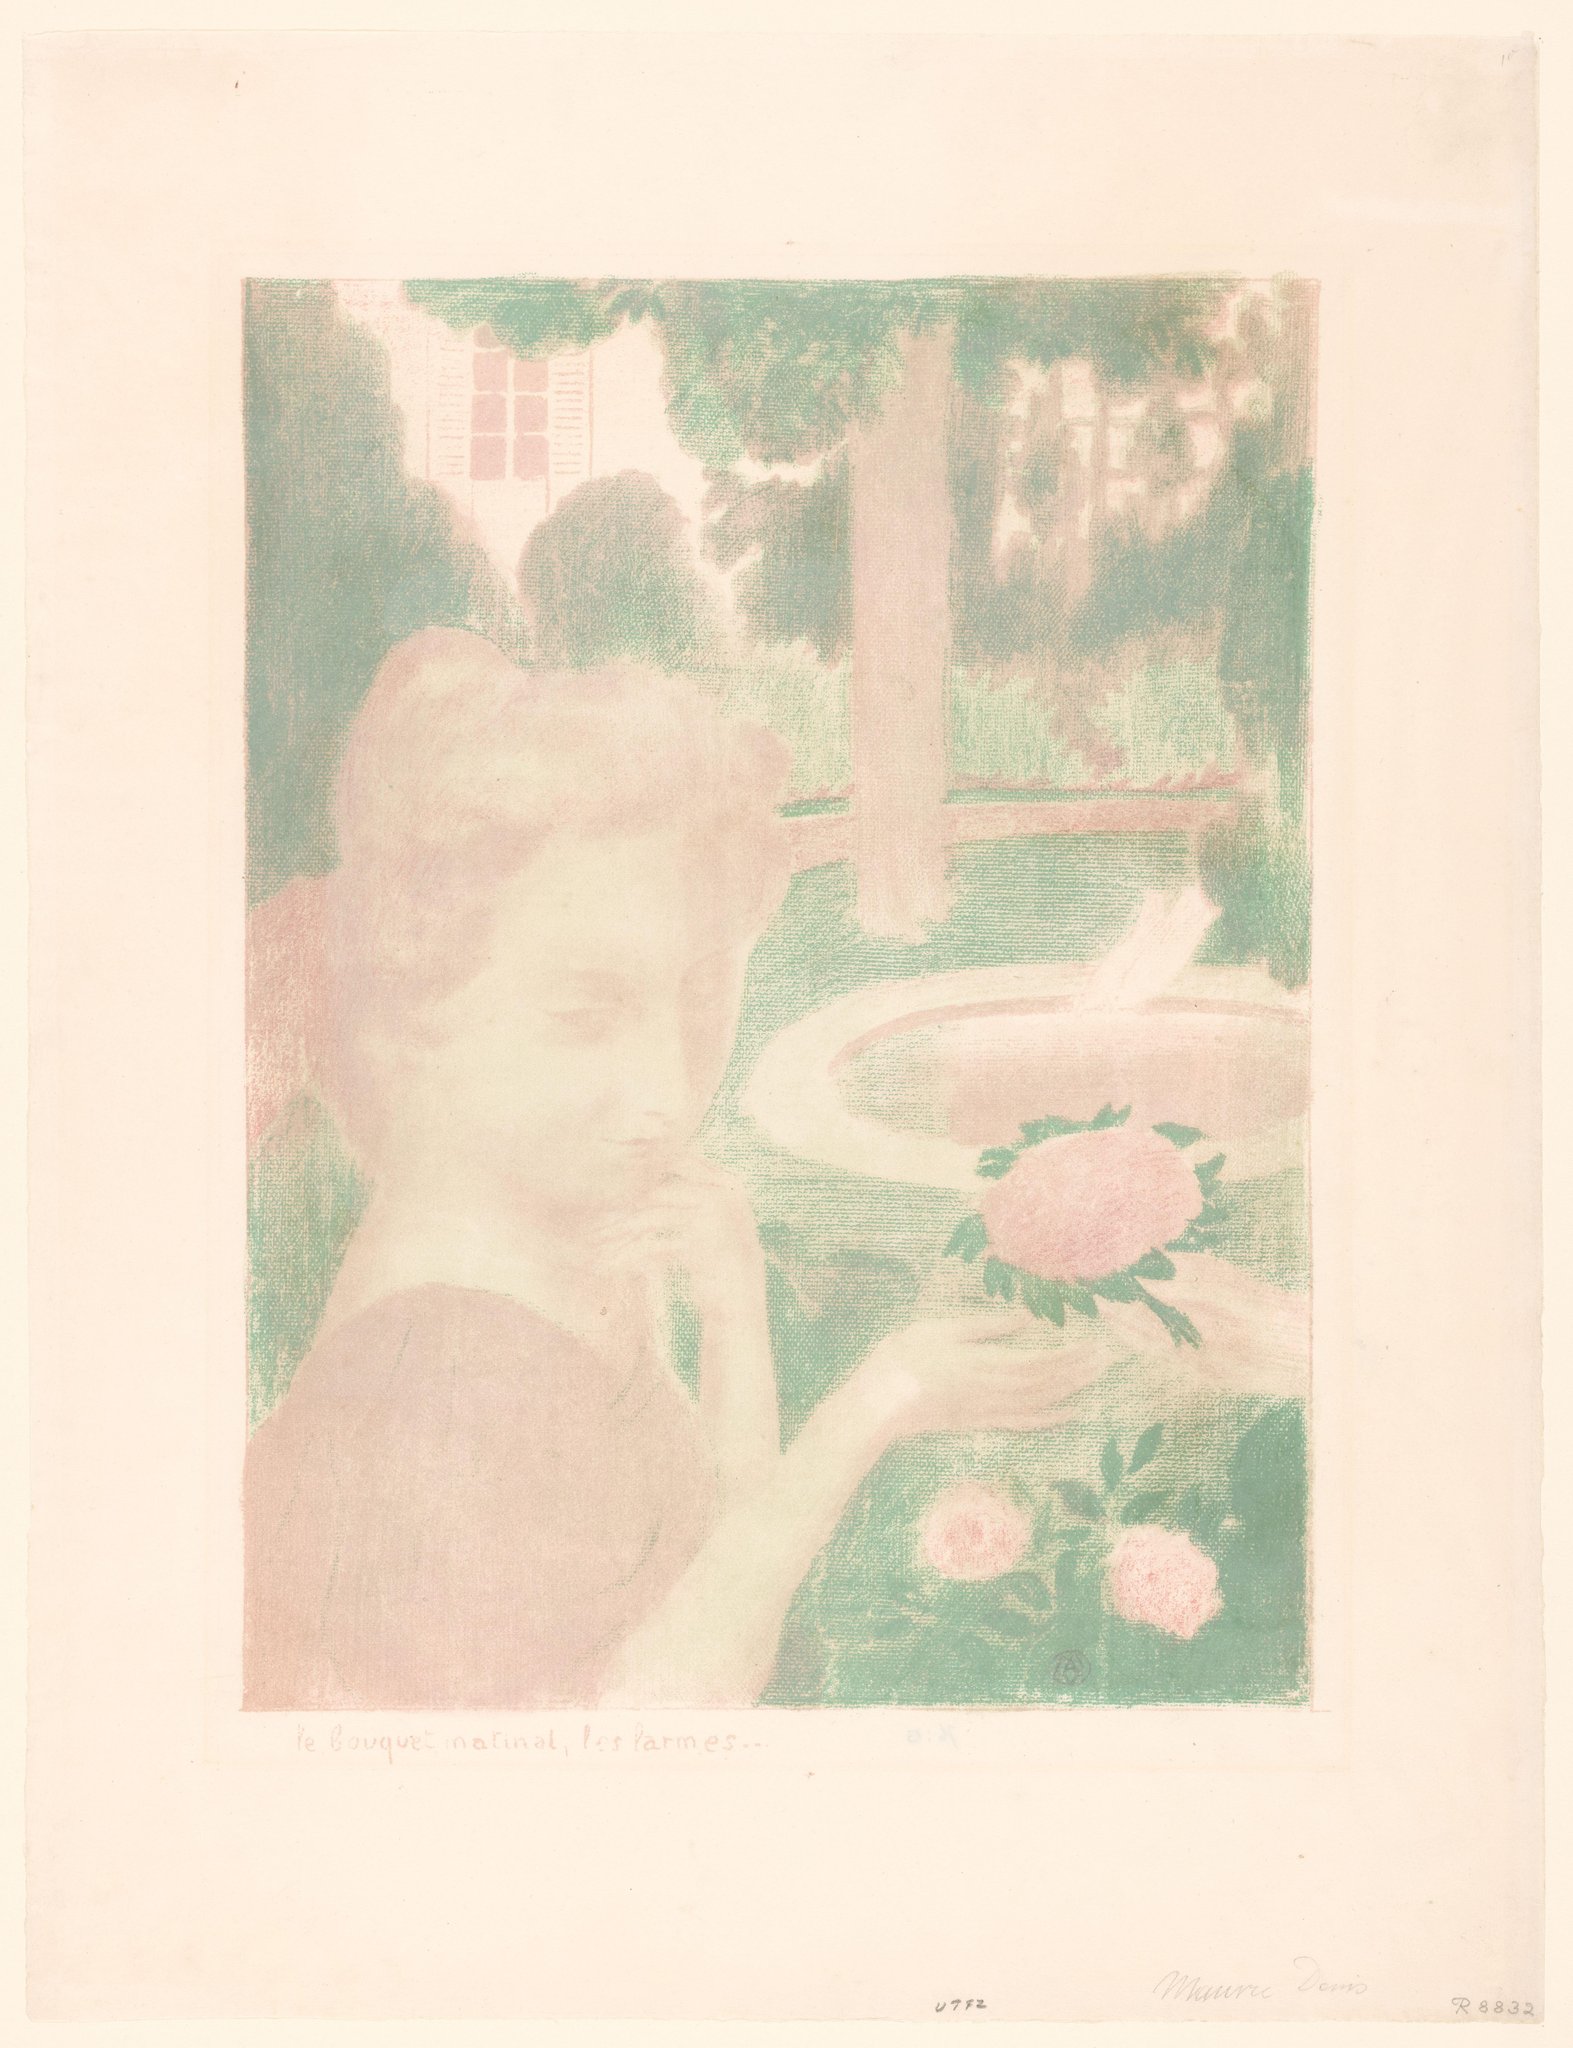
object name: print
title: Voorstellingen van de liefde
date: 1899-1911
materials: paper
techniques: oleograph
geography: paris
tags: cut flowers; nosegay, bunch of flowers, adult woman, garden, presents offered to the beloved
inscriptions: collector's mark: Lugt 2228a, collector's mark: Lugt 2760, initials: ‘AMV (?)’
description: Dit is de derde prent uit een serie van twaalf.